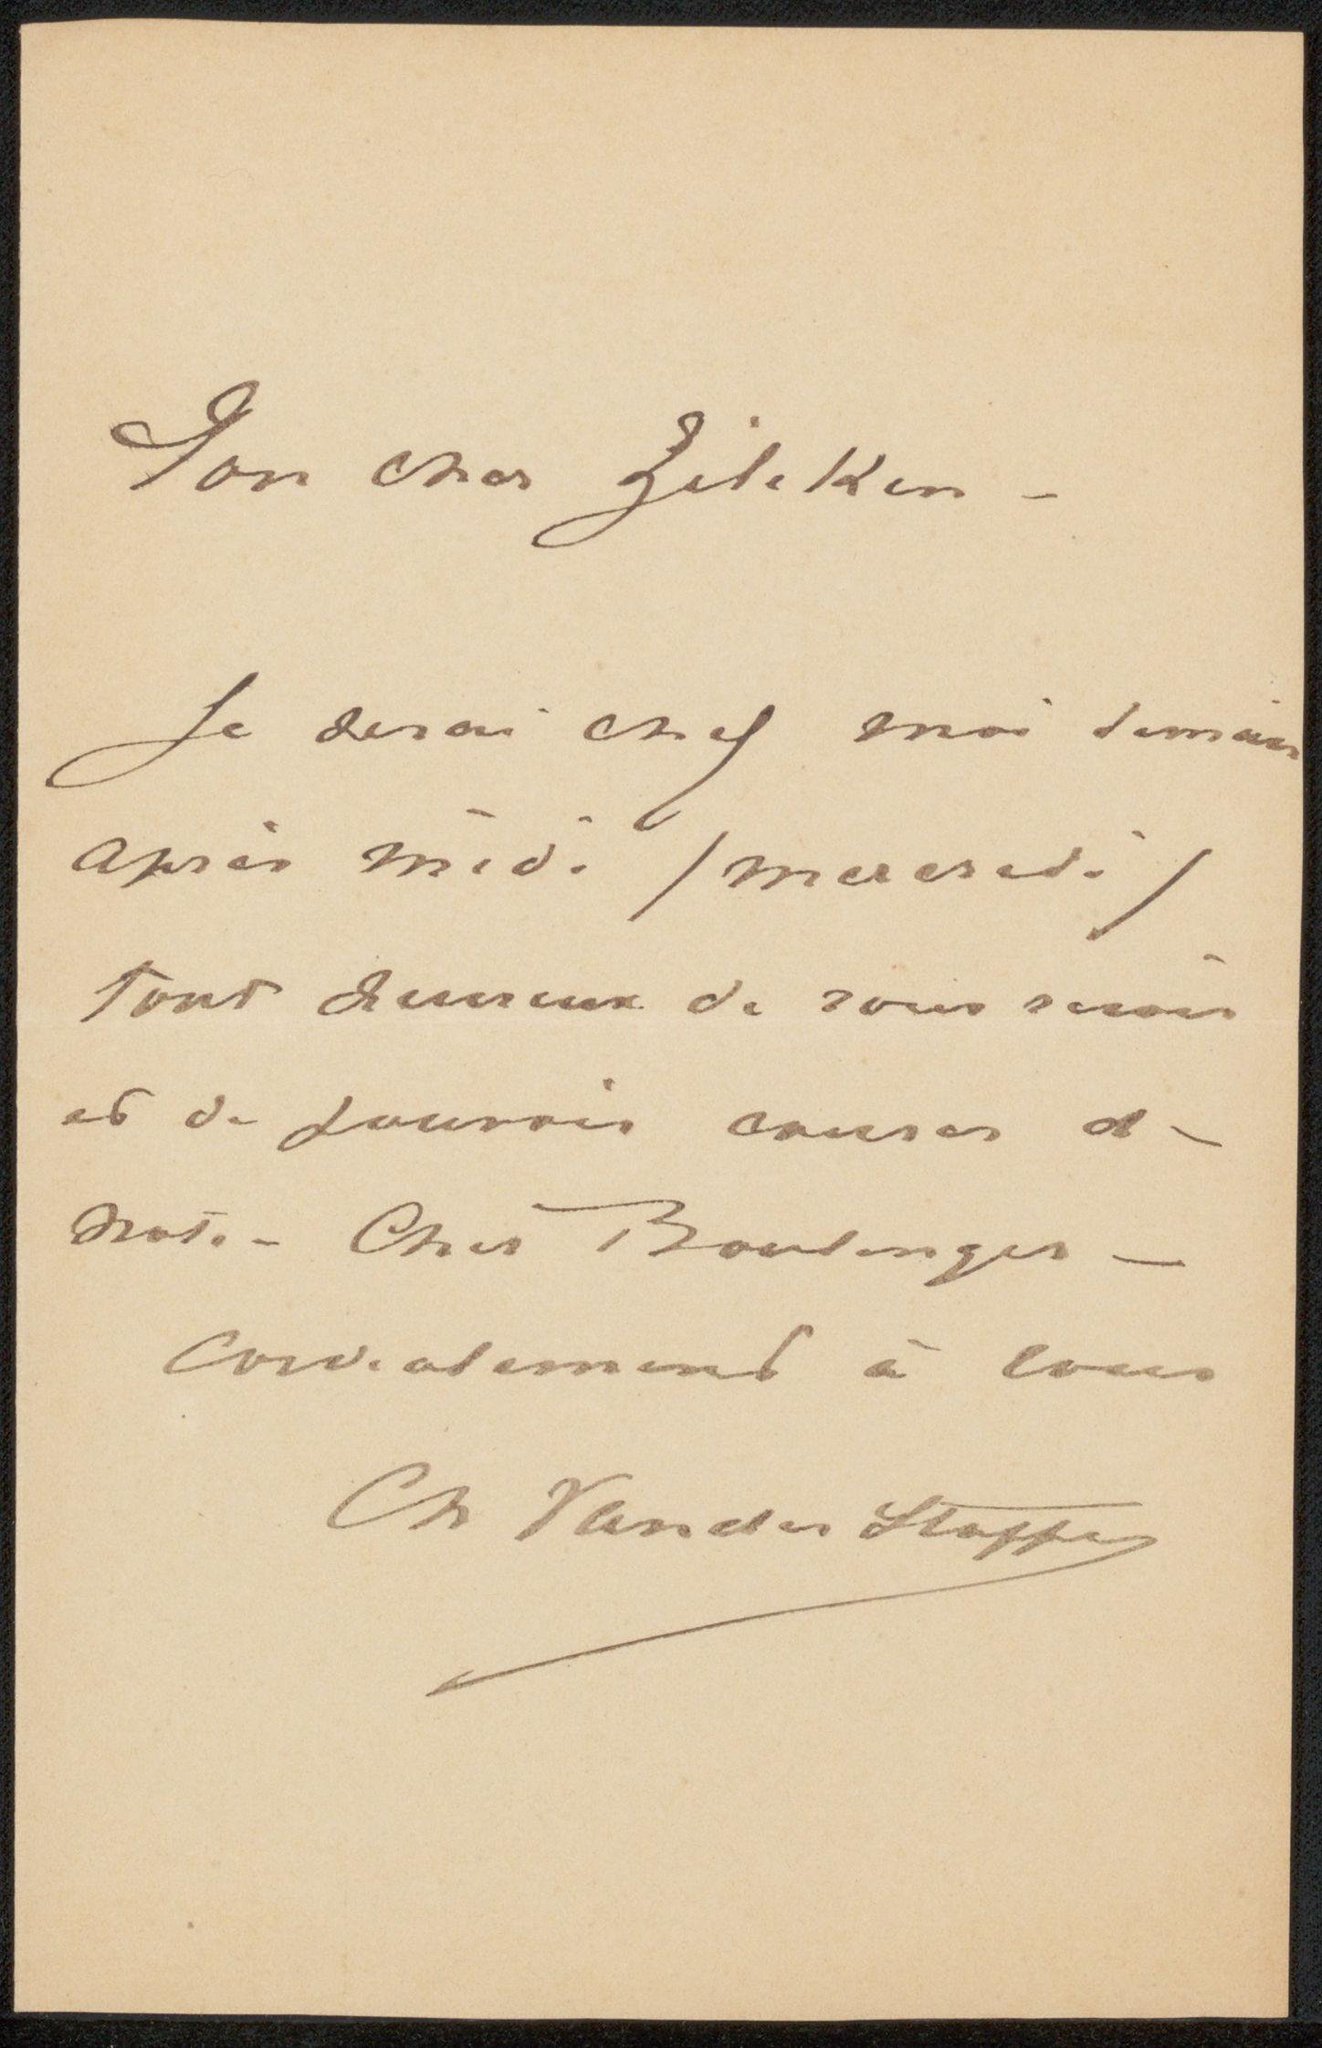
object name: letter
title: Brief aan Philip Zilcken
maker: charles van der stappen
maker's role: sculptor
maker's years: 1843-1910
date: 1867-1910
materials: ink, paper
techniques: pen, writing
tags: print maker, hippolyte emmanuel boulenger, the hague, painter, draughtsman, philip zilcken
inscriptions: collector's mark: ‘RPK’